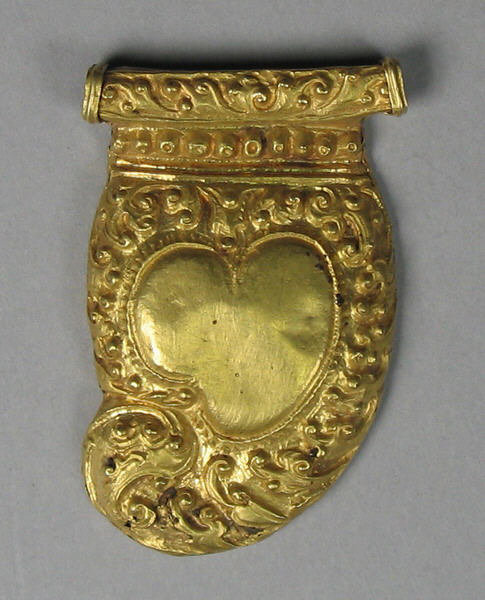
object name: pendant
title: Tiger Claw Pendant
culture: indonesian, central java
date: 701-1200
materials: gold